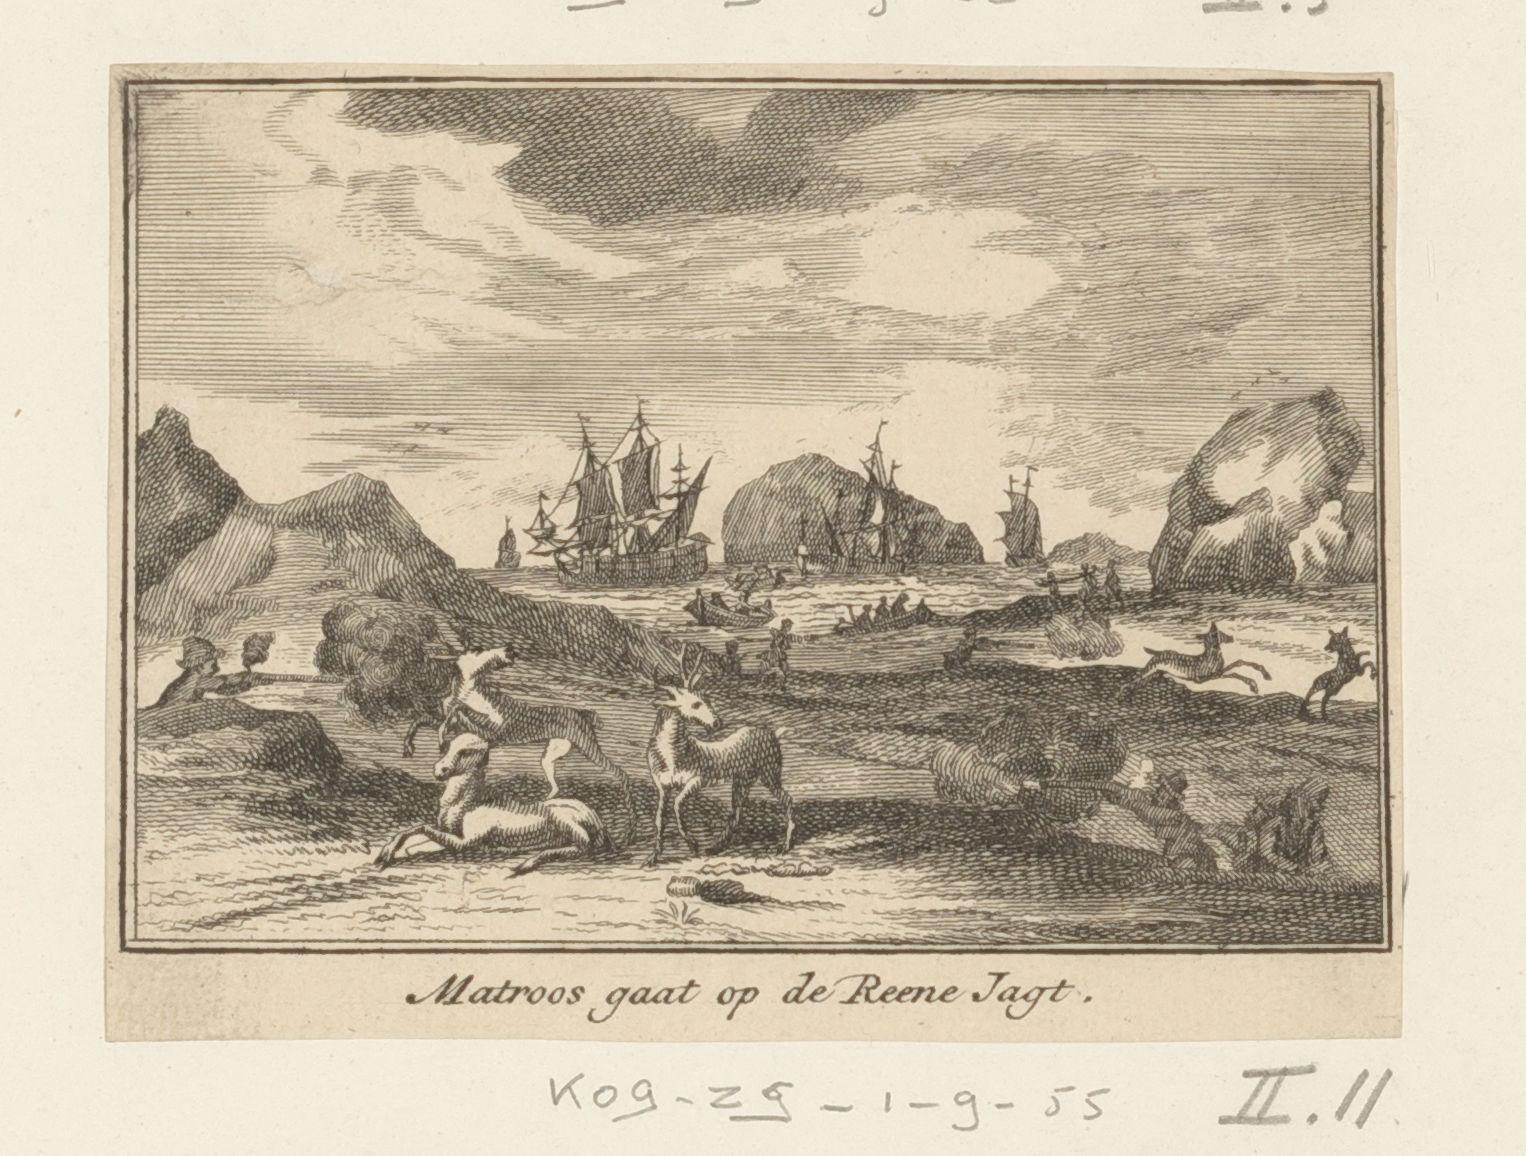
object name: print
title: Matrozen op de IJszee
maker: Anonymous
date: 1720-1770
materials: paper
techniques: engraving, etching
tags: roe-hunting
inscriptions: stamp, collector's mark: Lugt 1641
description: Prenten zijn een verkleinde versie van de serie Groote Visserij, Visschers Atlas tot Amsterdam. Prenten door Adolf van der Laan, naar tekeningen van Sieuwert van der Meulen en uitgegeven door Pieter Schenk II. De serie bestaat uit zeventien platen over de haringvisserij en zestien platen over de walvisvangst. De serie is waarschijnlijk rond 1720 uitgegeven. De kleine prenten werden met vier voorstellingen op een plaat gedrukt. Elke afbeelding werd genummerd.